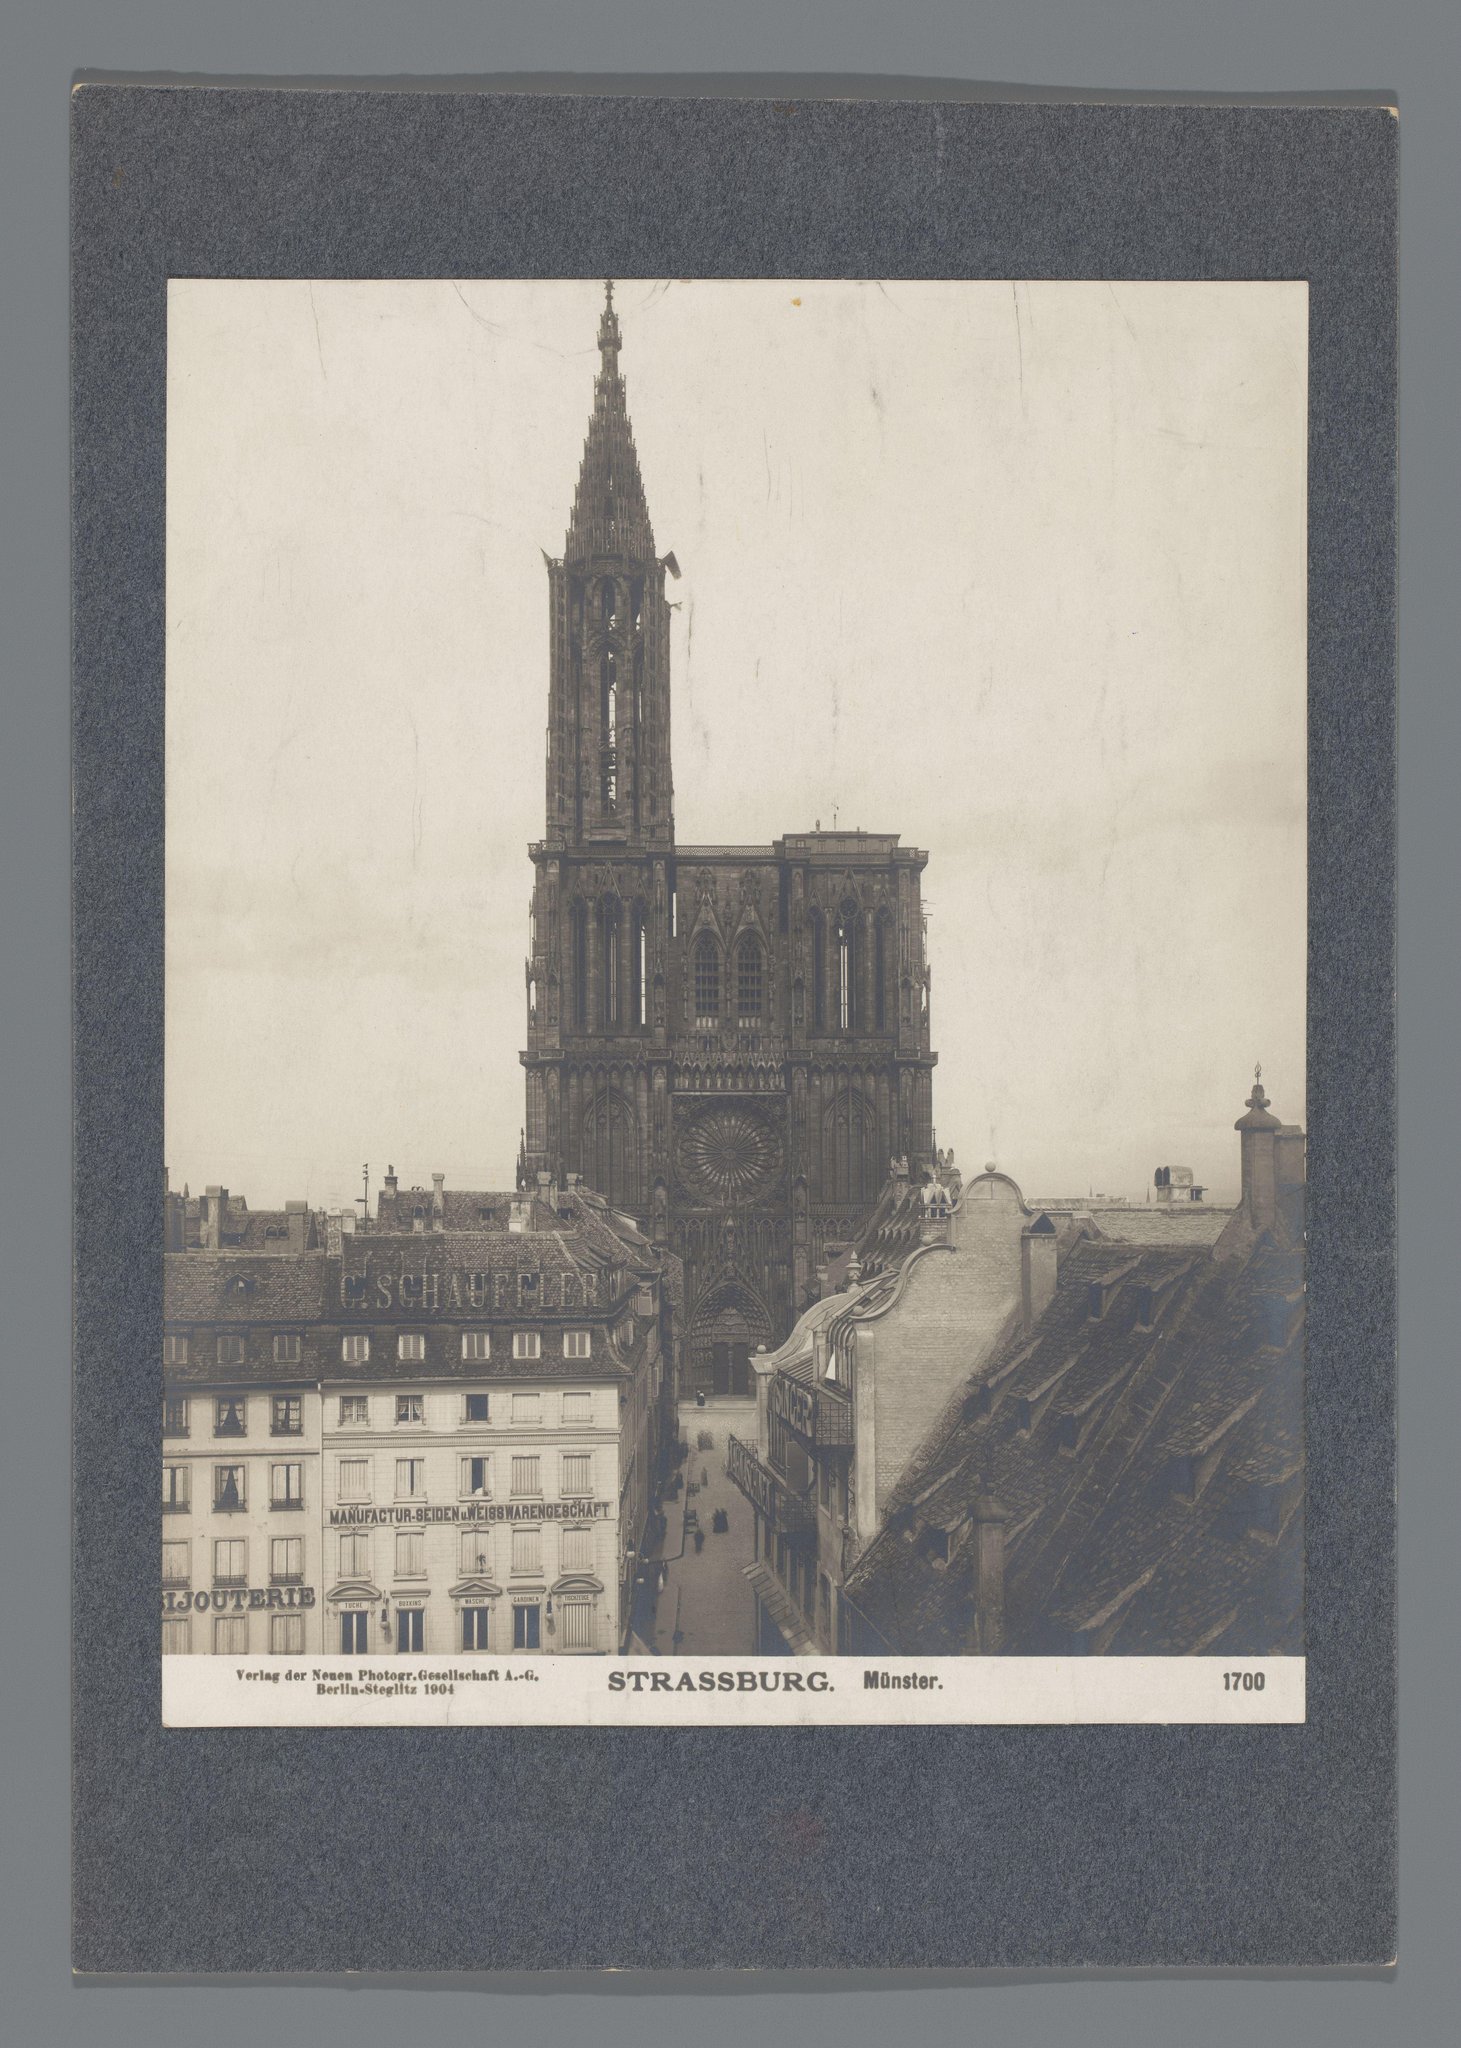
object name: photograph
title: Strassburg. Münster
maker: Anonymous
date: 1880-1930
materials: photographic support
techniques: gelatin silver print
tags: münster, straatsburg (frankrijk)